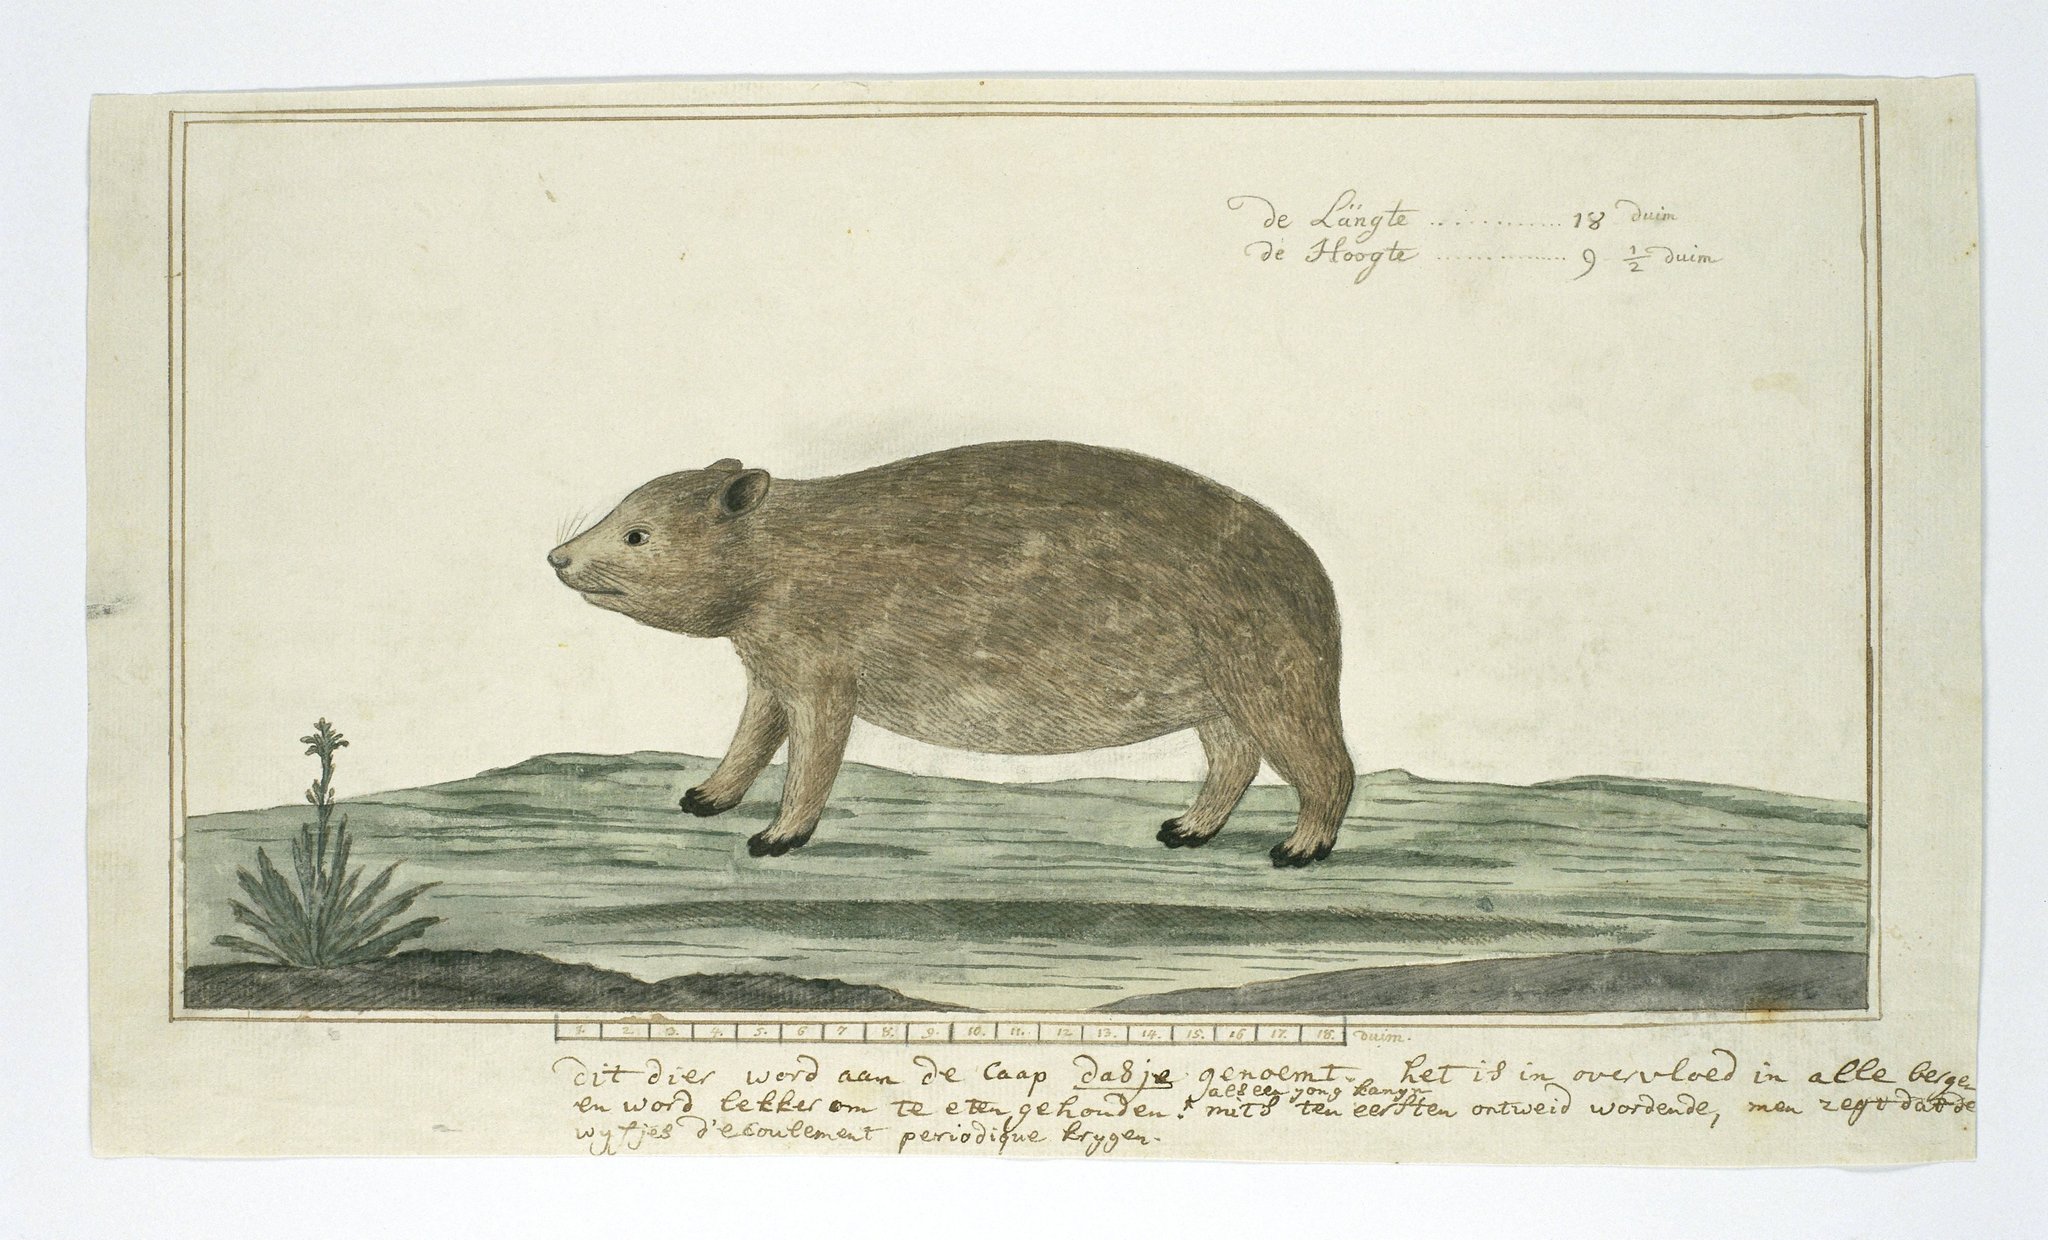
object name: drawing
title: Procavia capensis (Rock hyrax or dassie)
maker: robert jacob gordon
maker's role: draughtsman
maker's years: 1743-1795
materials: chalk, ink, paper, pencil, watercolor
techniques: brush, pen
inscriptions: annotation: ‘dit dier word aan de Caap dasje [onderstreept] genoemt. [...]’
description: Klipdas (Procavia capensis), of Kaaps dasje; met schaalverdeling in Rijnlandse duim.